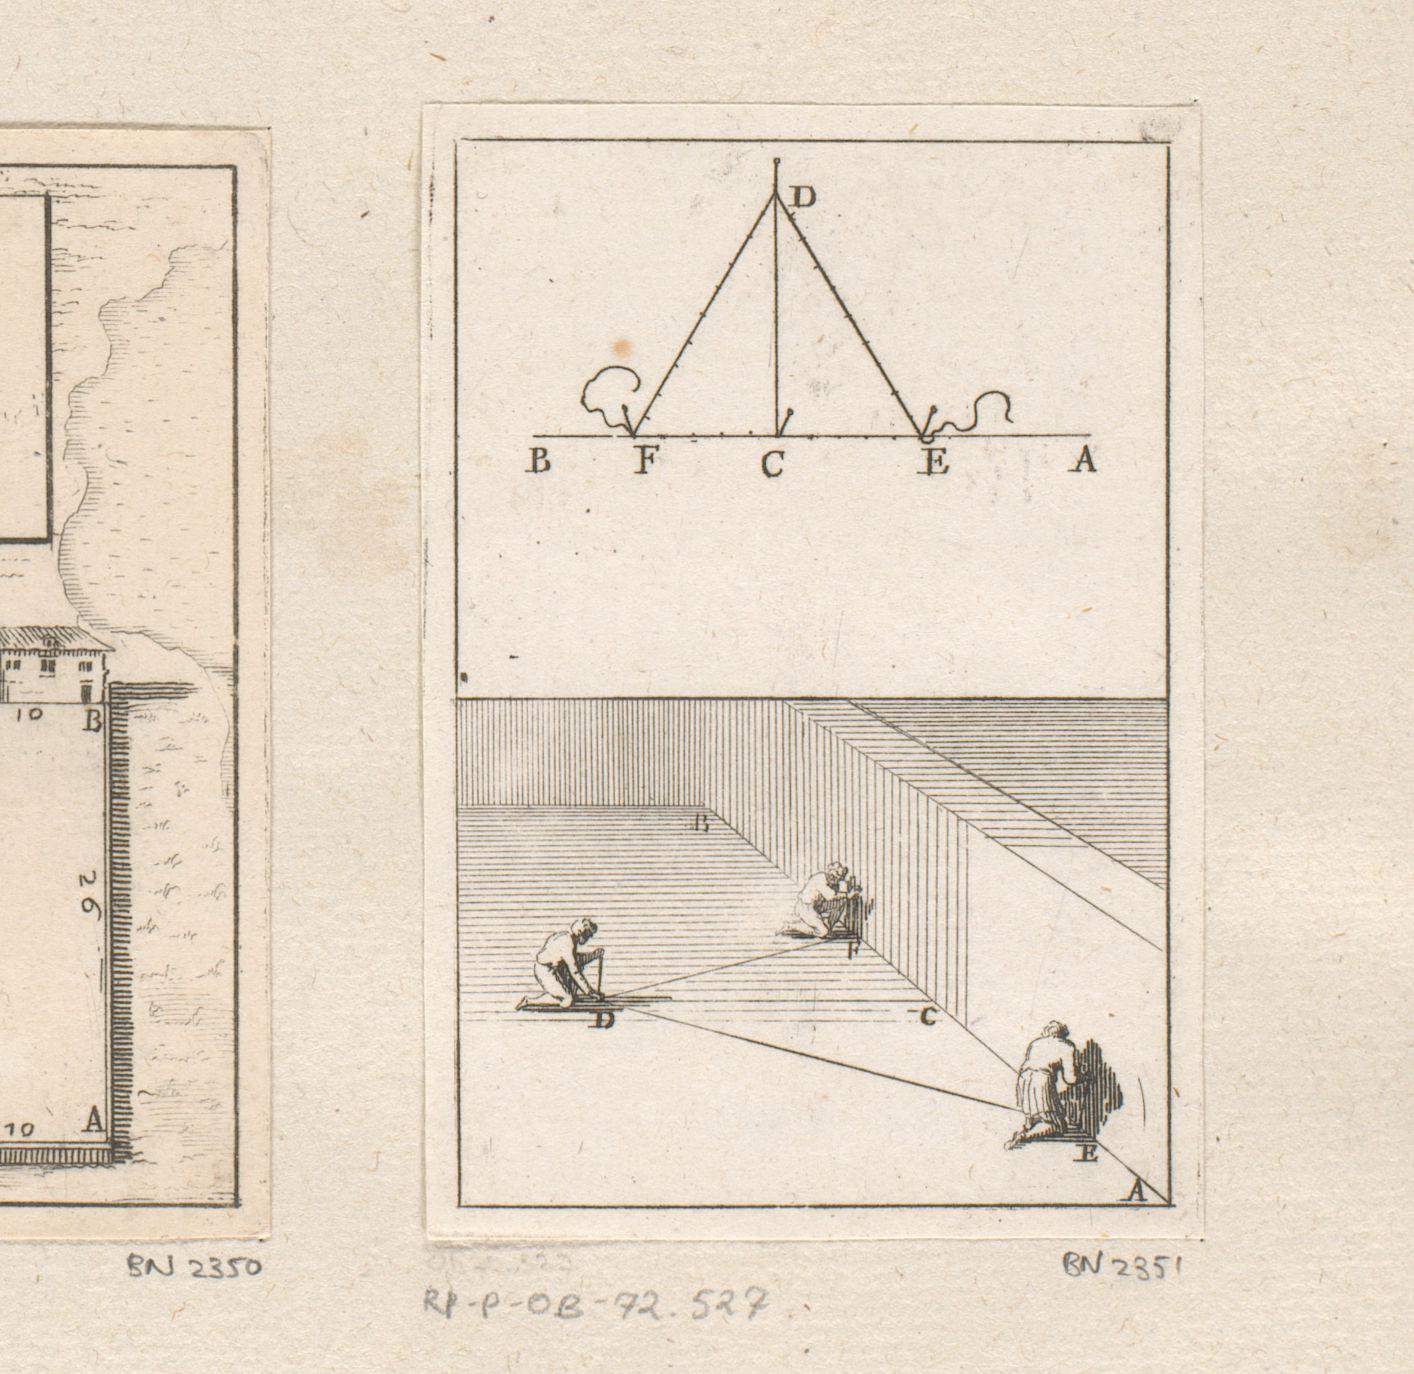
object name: book illustration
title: Lijn vanuit een punt die gelijke hoeken maakt met een muur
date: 1669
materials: paper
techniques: etching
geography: paris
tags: planimetry, geometry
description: Prent toegevoegd aan: Pratique de la géometrie, sur le papier et sur le terrain. Avec un nouvel ordre et une méthode particulière. Parijs: Thomas Jolly, 1669.